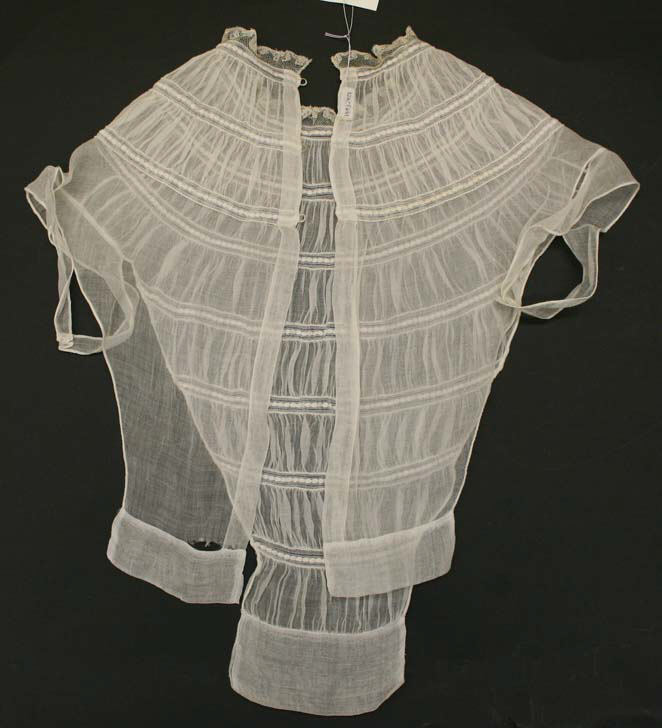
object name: chemise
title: Chemisette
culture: british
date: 1847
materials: cotton